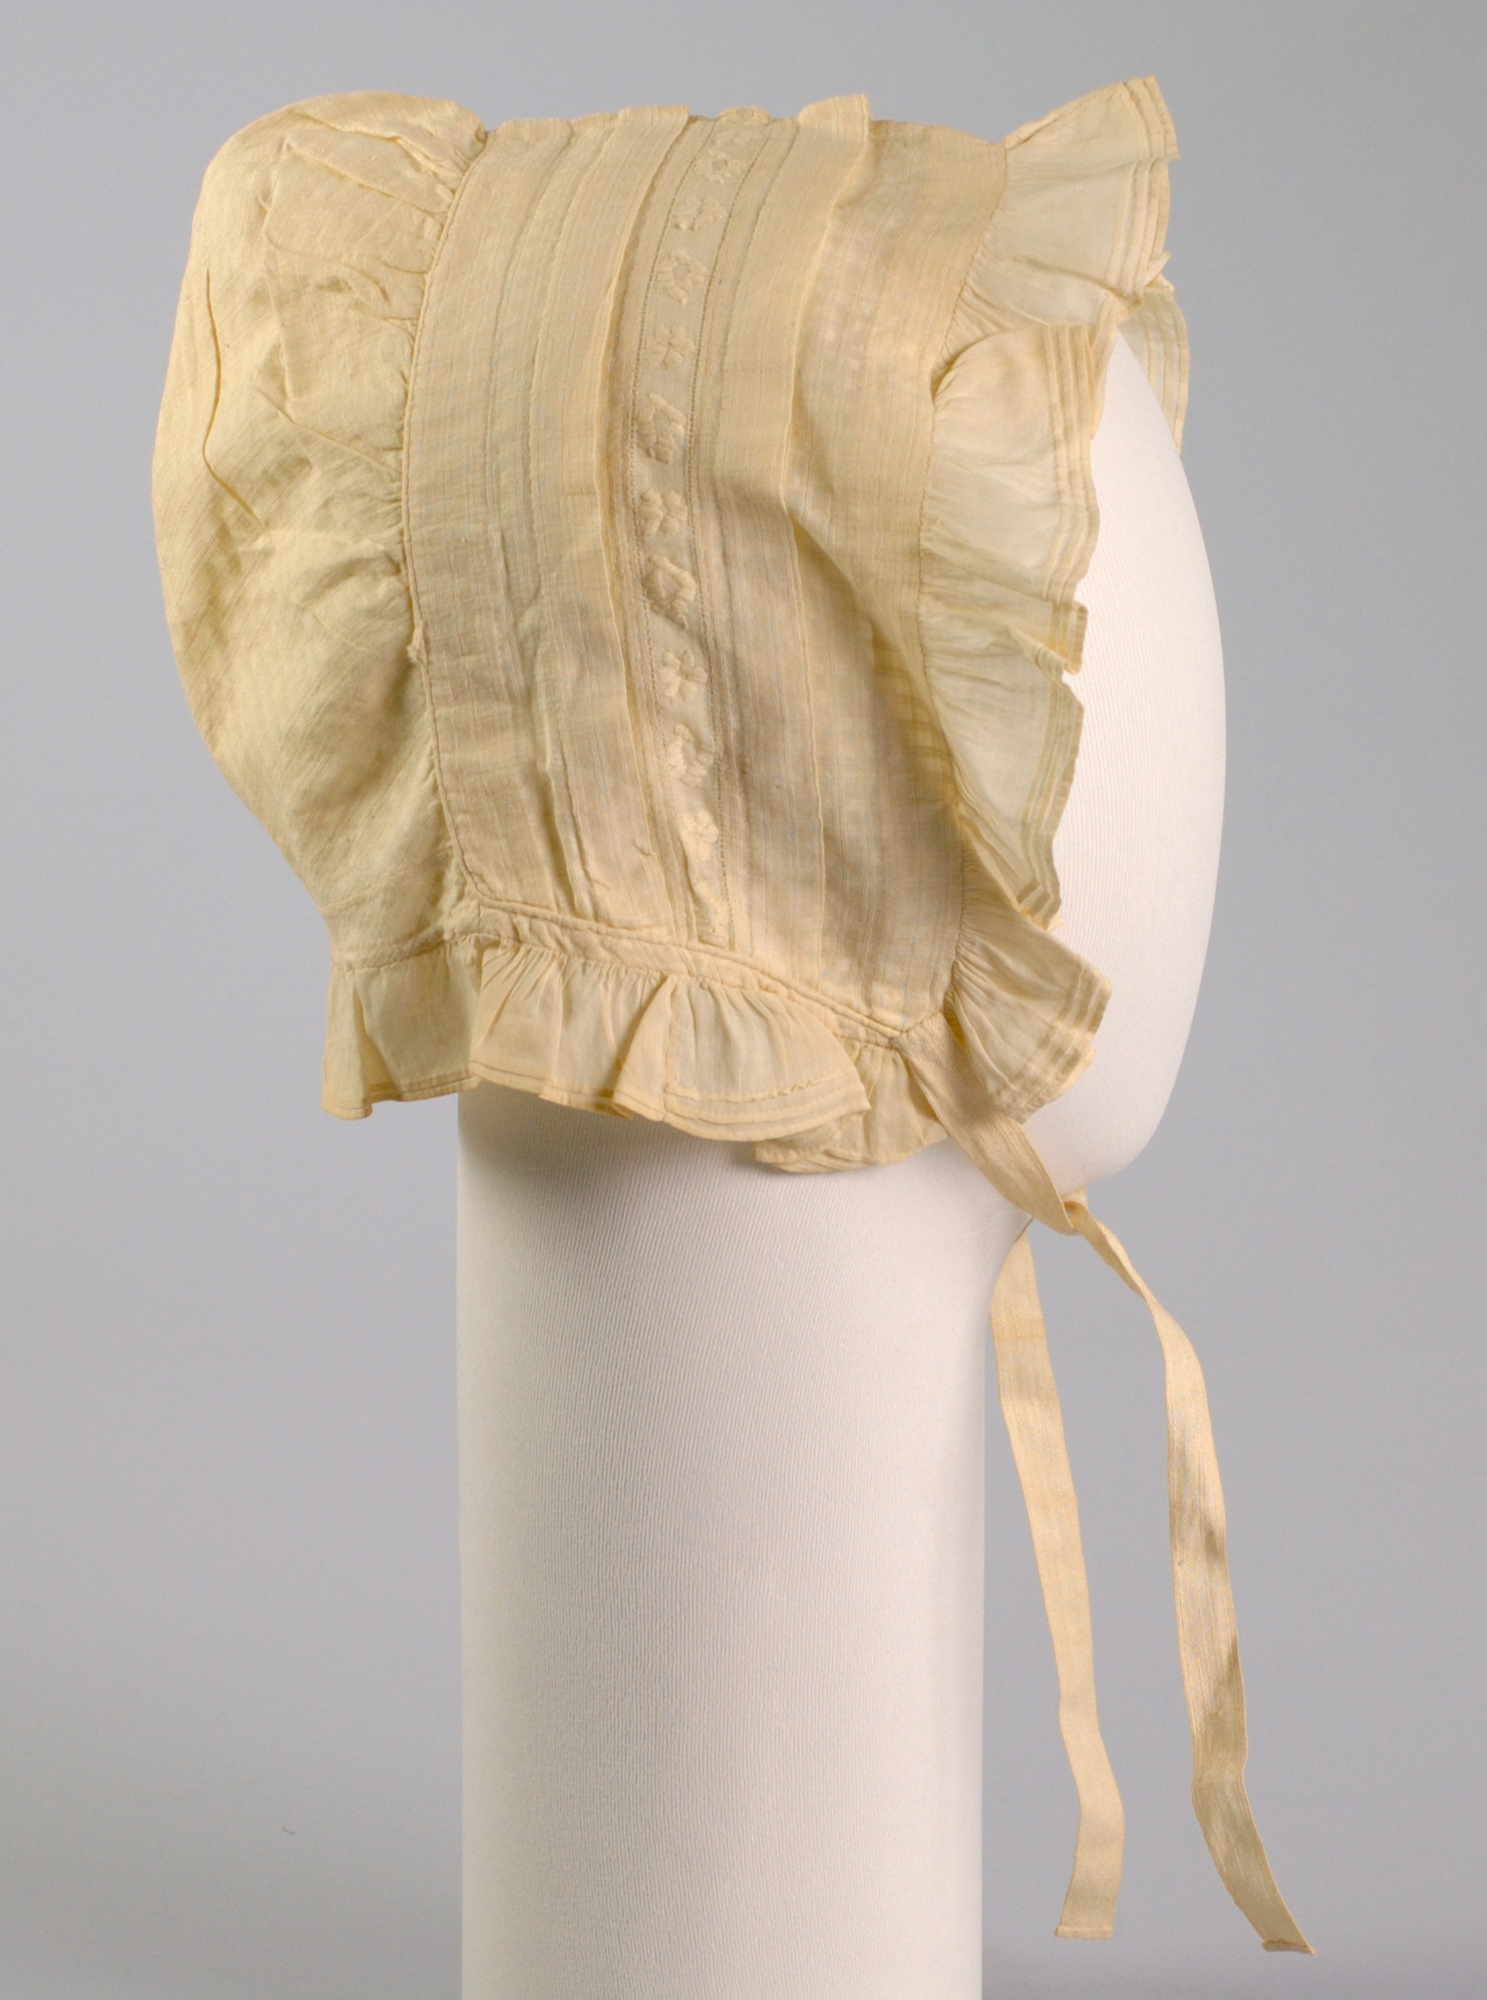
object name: nightcap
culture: american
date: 1850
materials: cotton